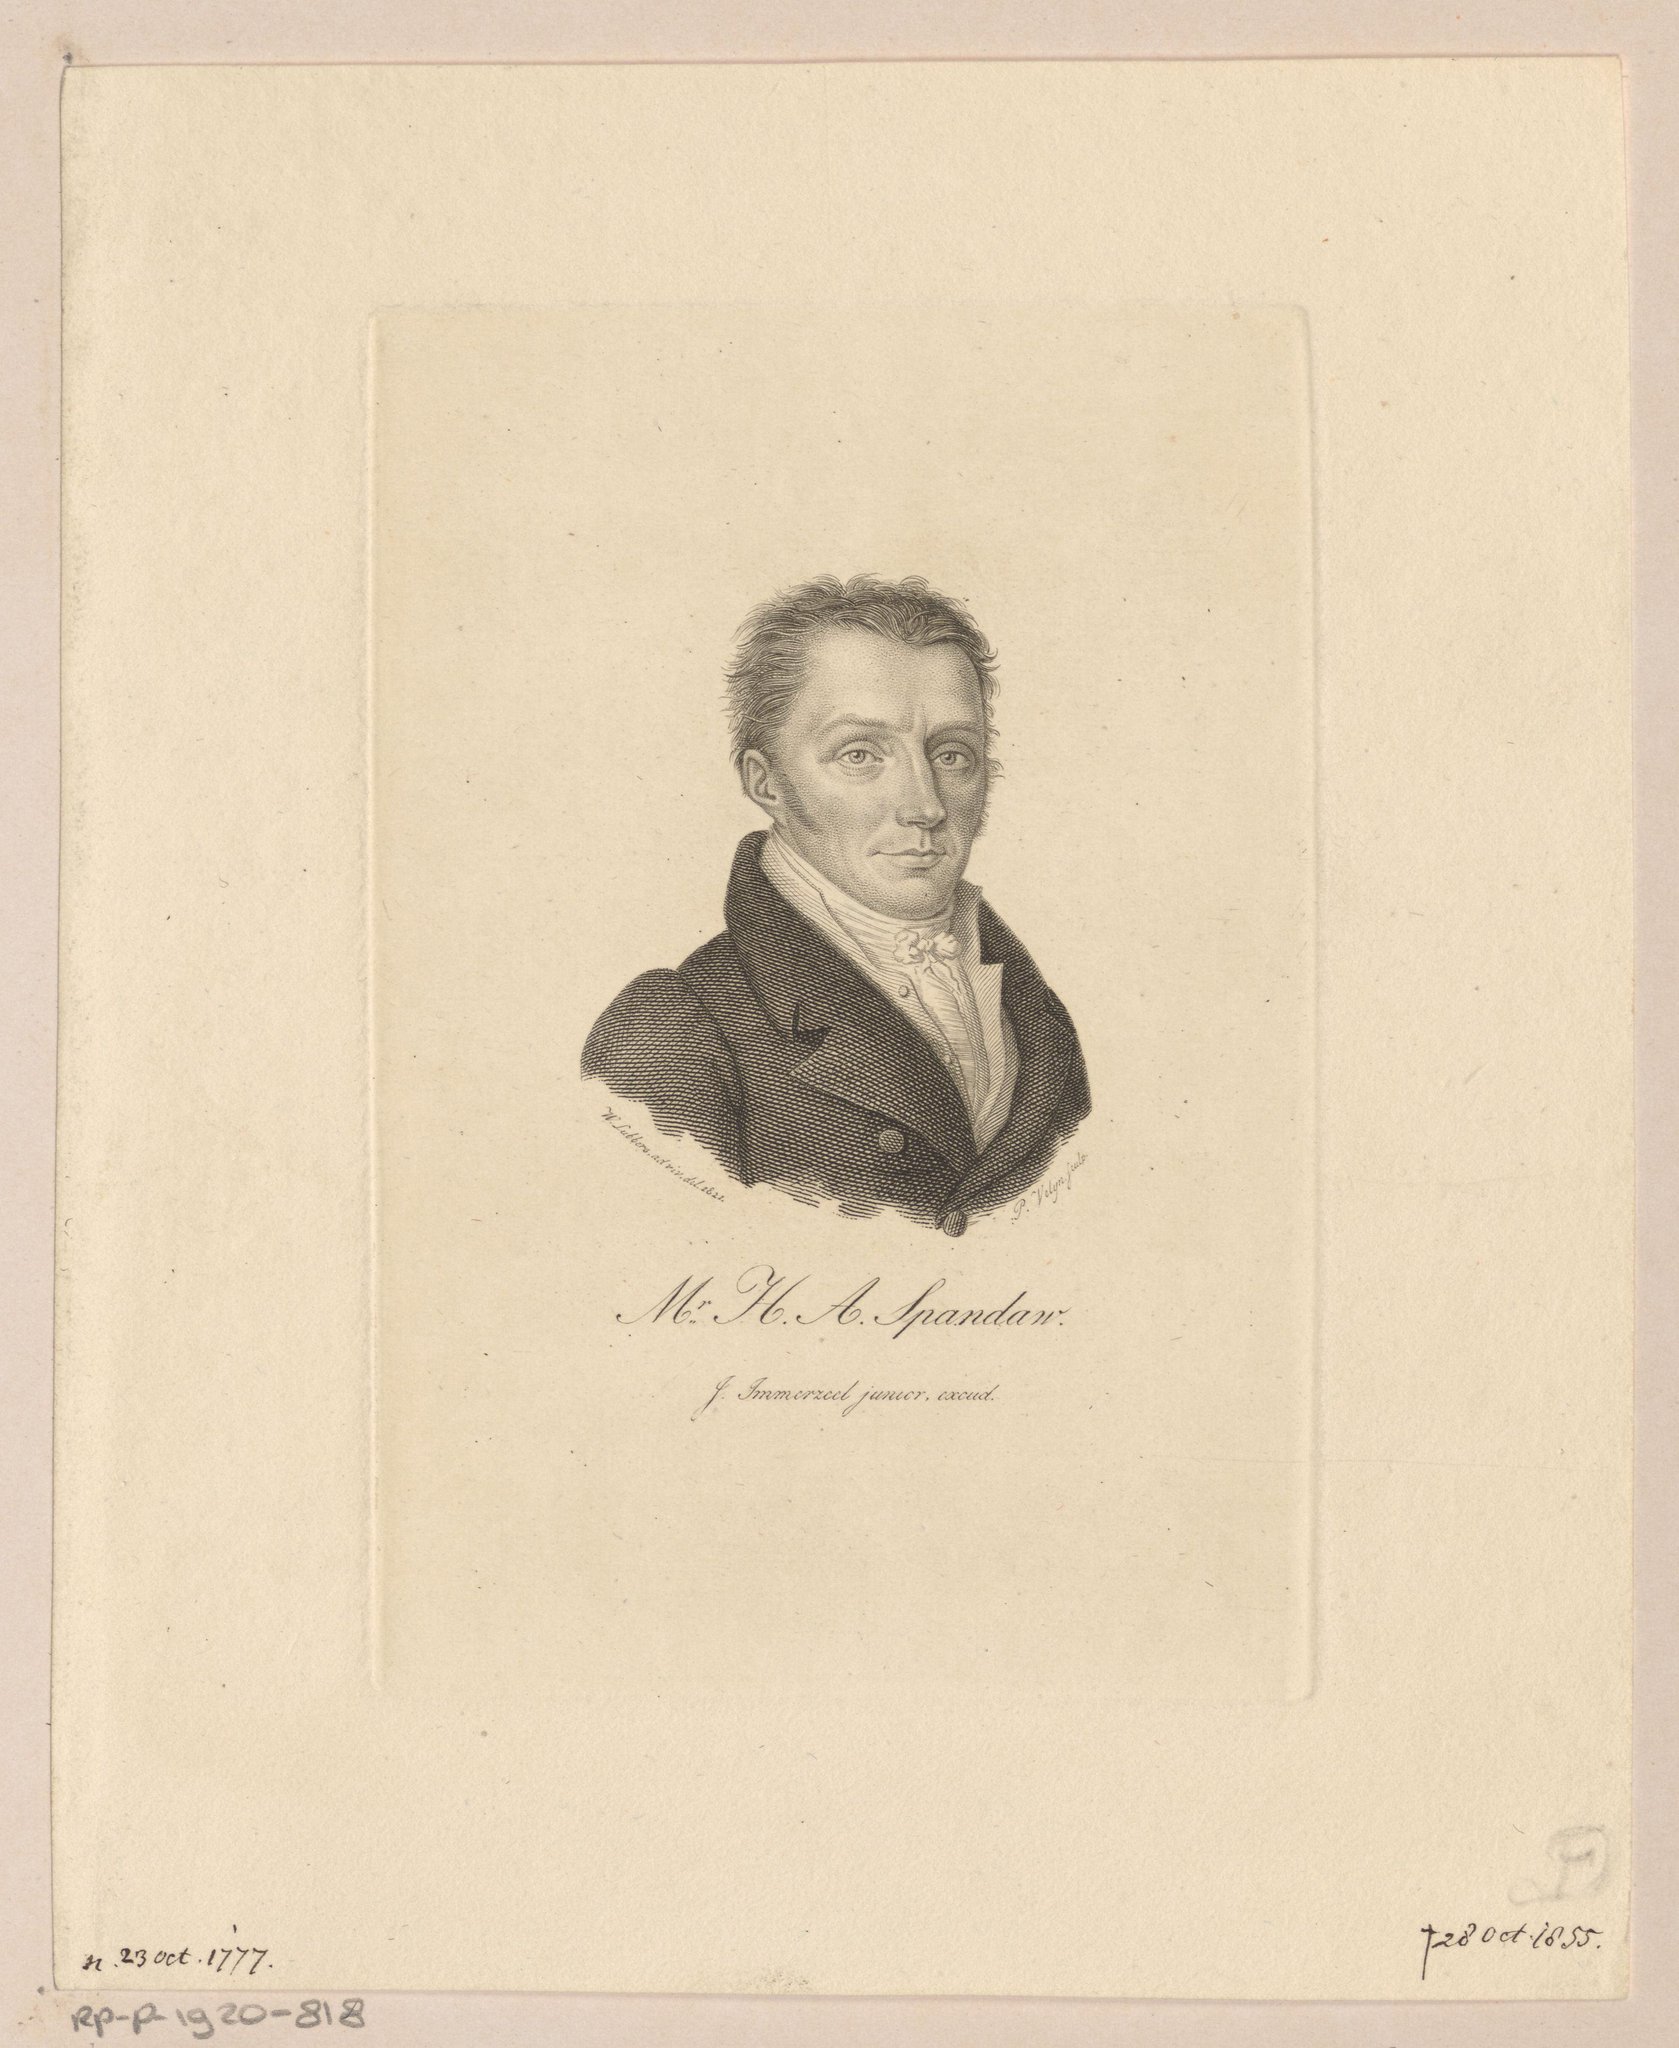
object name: print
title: Portret van Hajo Albert Spandaw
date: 1822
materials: paper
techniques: engraving, etching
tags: hajo albert spandaw, historical persons, portrait of a writer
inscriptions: collector's mark: Lugt 2228, inscription: ‘n. 23 oct. 1777. +28 oct. 1855.’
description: Prent volgens Van Someren ook gebruikt in: Nederlandsche Muzen-Almanak. Rotterdam: Johannes Immerzeel, 1822.